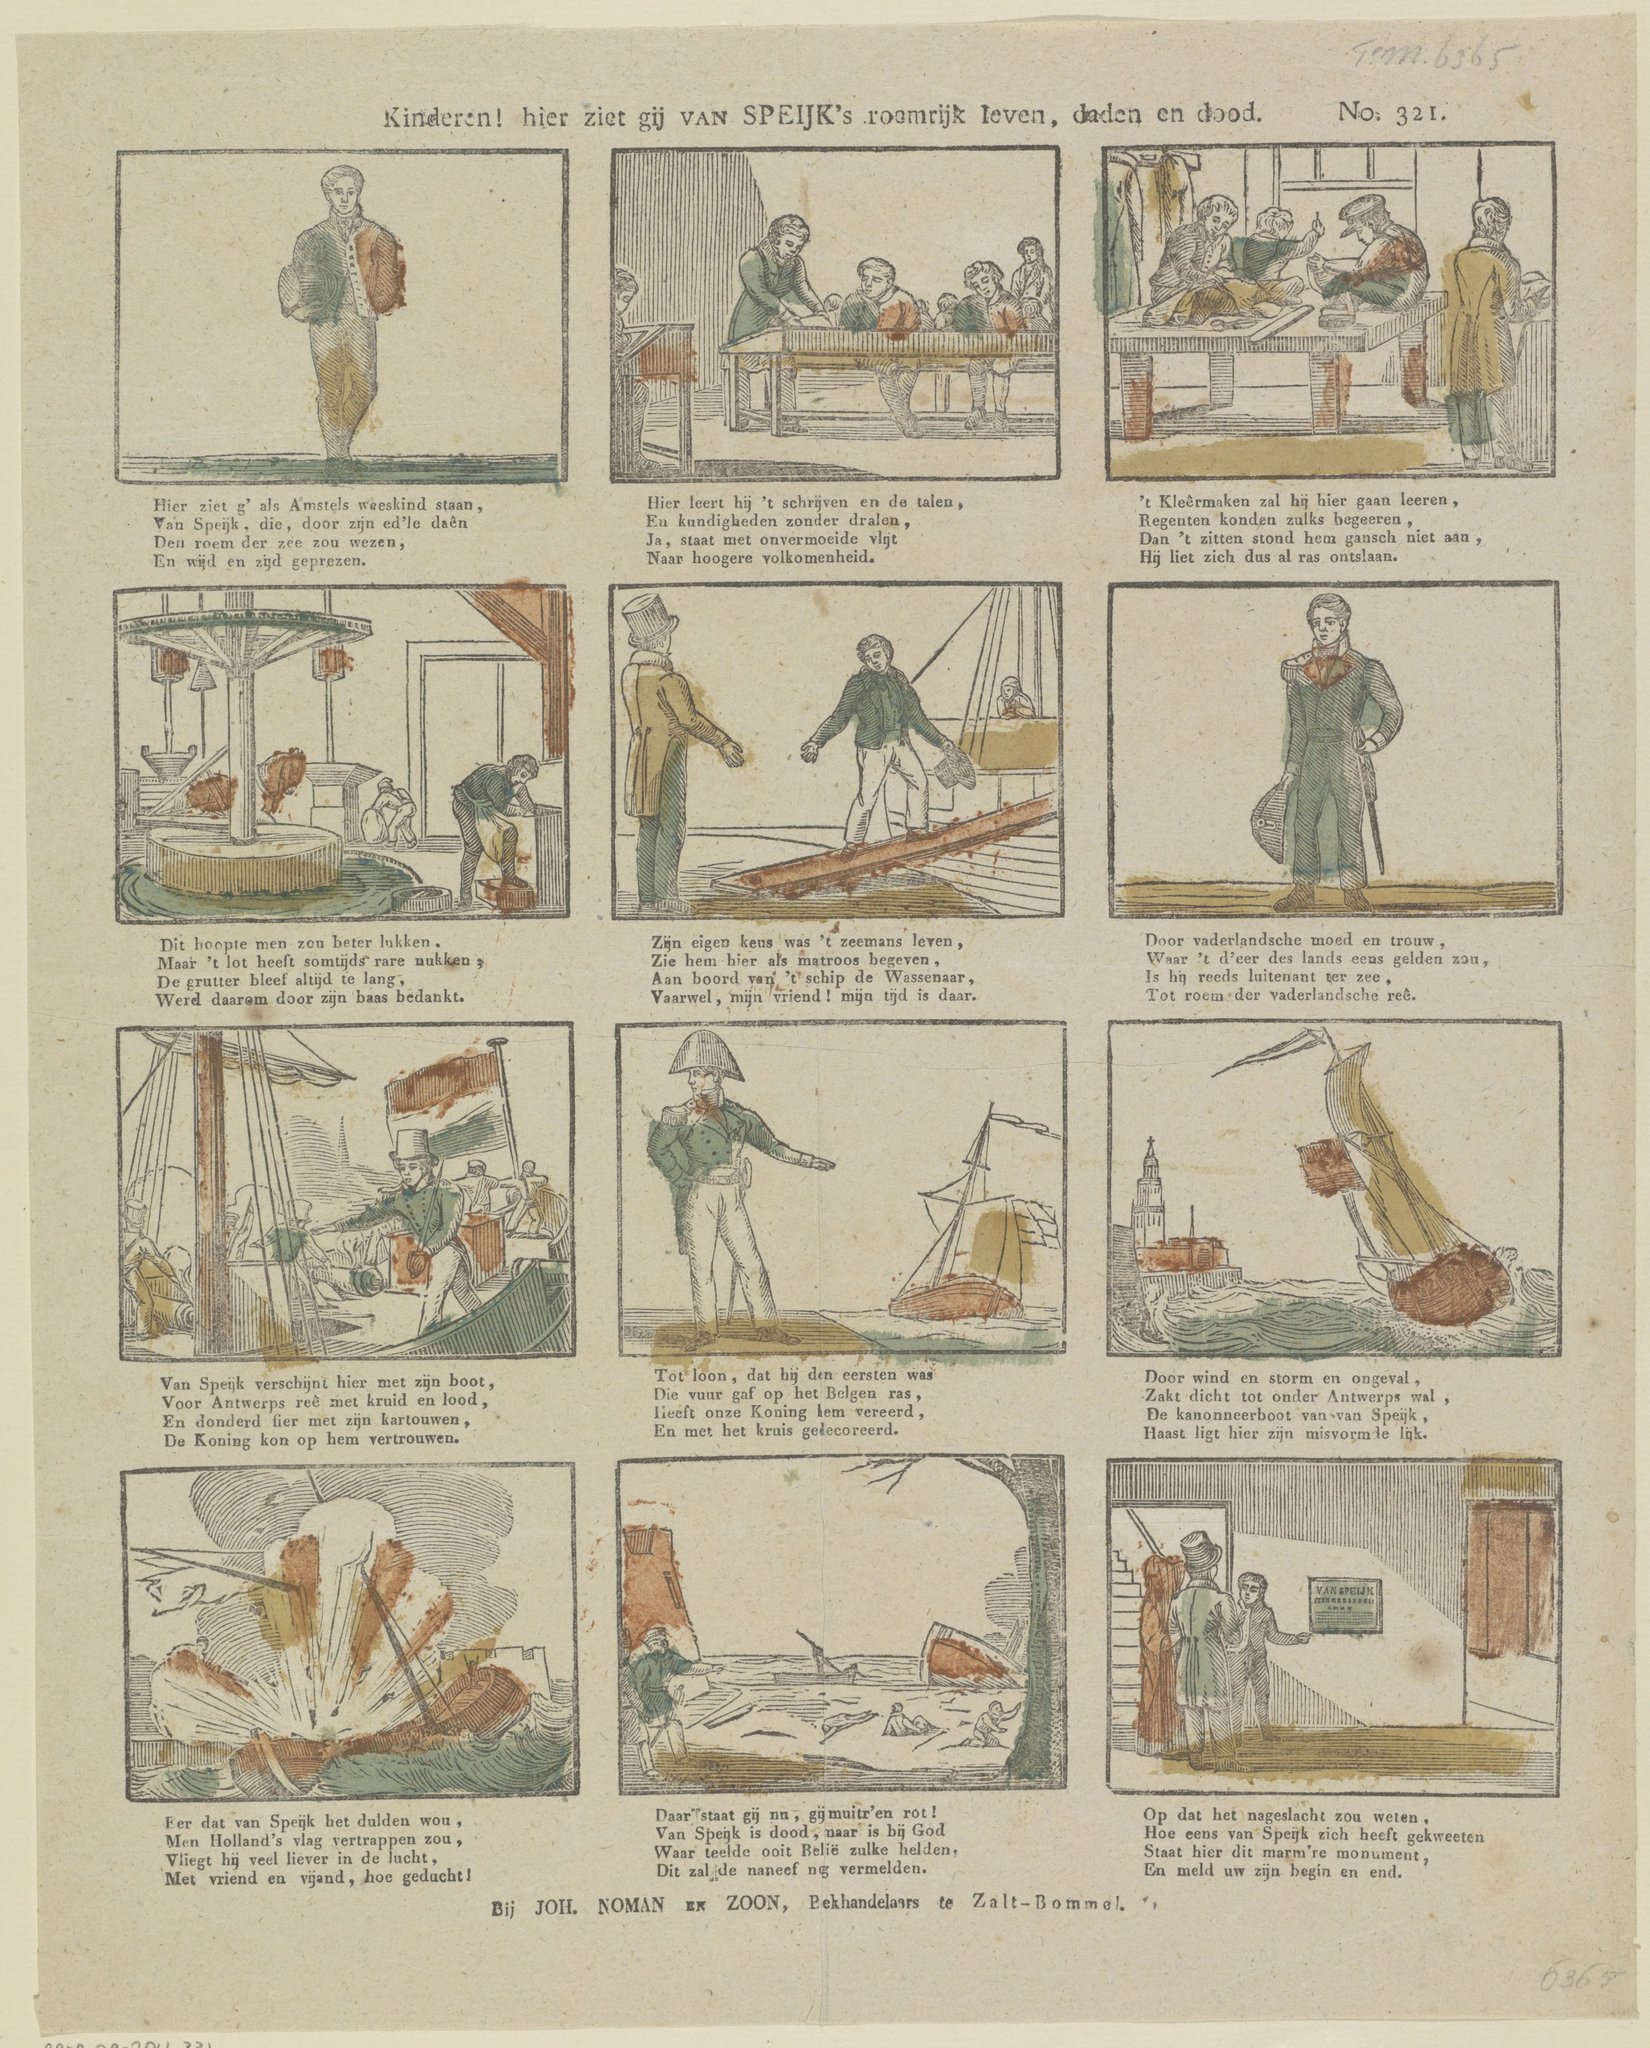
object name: popular print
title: Kinderen! hier ziet gij van Speijk's roomrijk leven, daden en dood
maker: Anonymous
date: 1830-1892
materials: paper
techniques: colour, letterpress printing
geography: netherlands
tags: amsterdam, antwerp, jan van speyk, battle, revolution, revolt, orphans, belgium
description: Blad met 12 voorstellingen over het leven en de zelfopoffering van J.C.J. van Speyk tijdens de strijd tegen de Belgen. Onder elke afbeelding een vierregelig vers. Genummerd rechtsboven: No. 321.